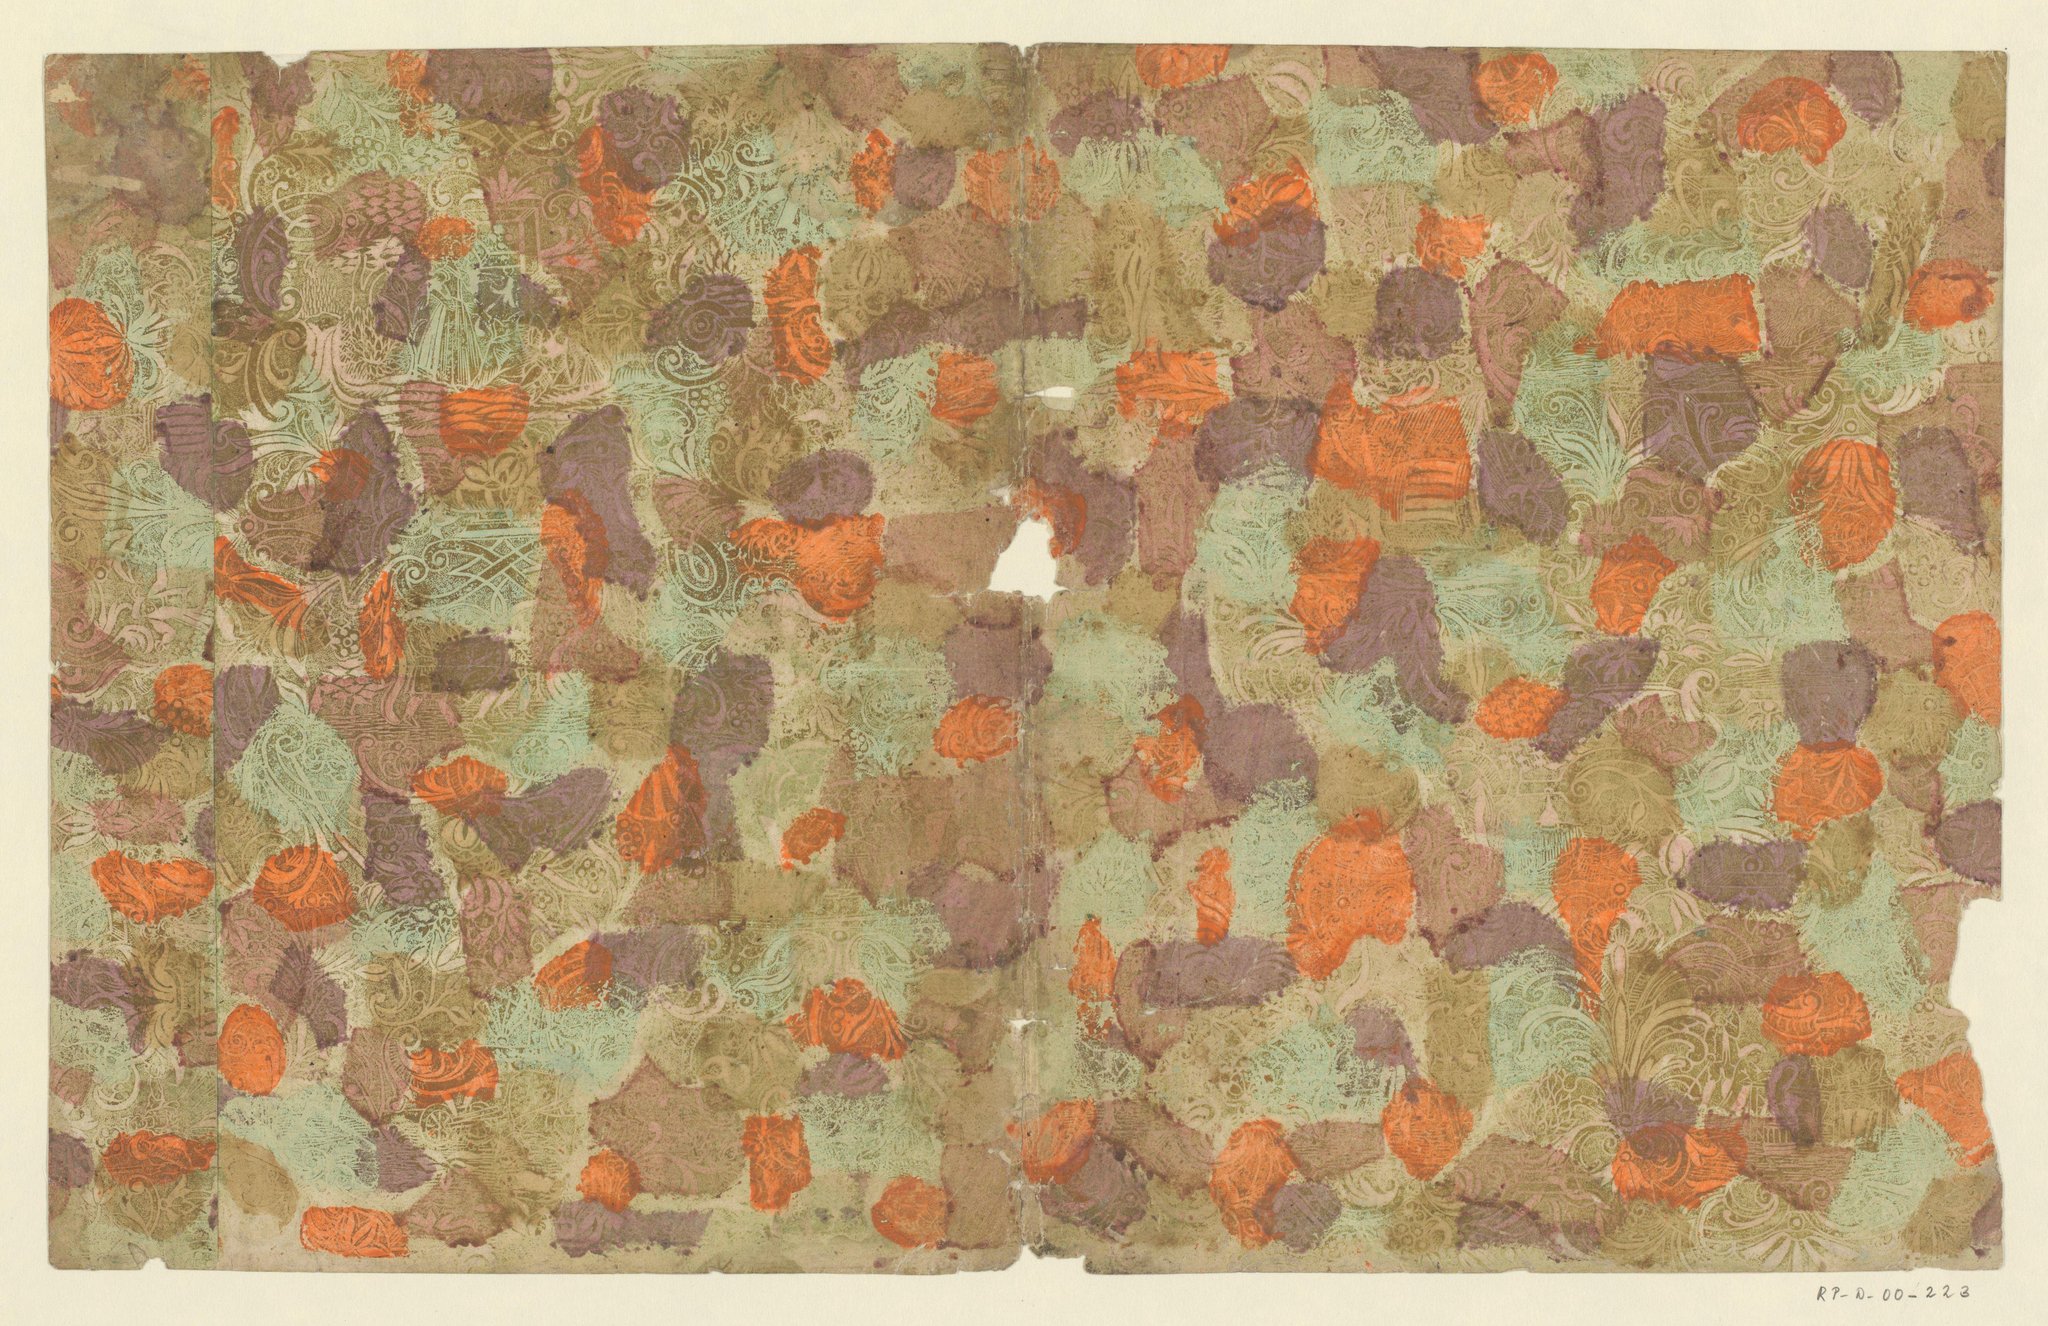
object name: brocade paper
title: Blad met ranken met bloemen en mensen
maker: Anonymous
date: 1750-1820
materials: gold leaf, paint, paper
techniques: relief print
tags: anthropomorphic ornament, ornament derived from plant forms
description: Blad met ranken met bloemen en mensen, linksboven een staande vrouw, linksonder een paard en wagen, rechtsonder figuren gezeten aan een tafel. Gebruikt als omslag.